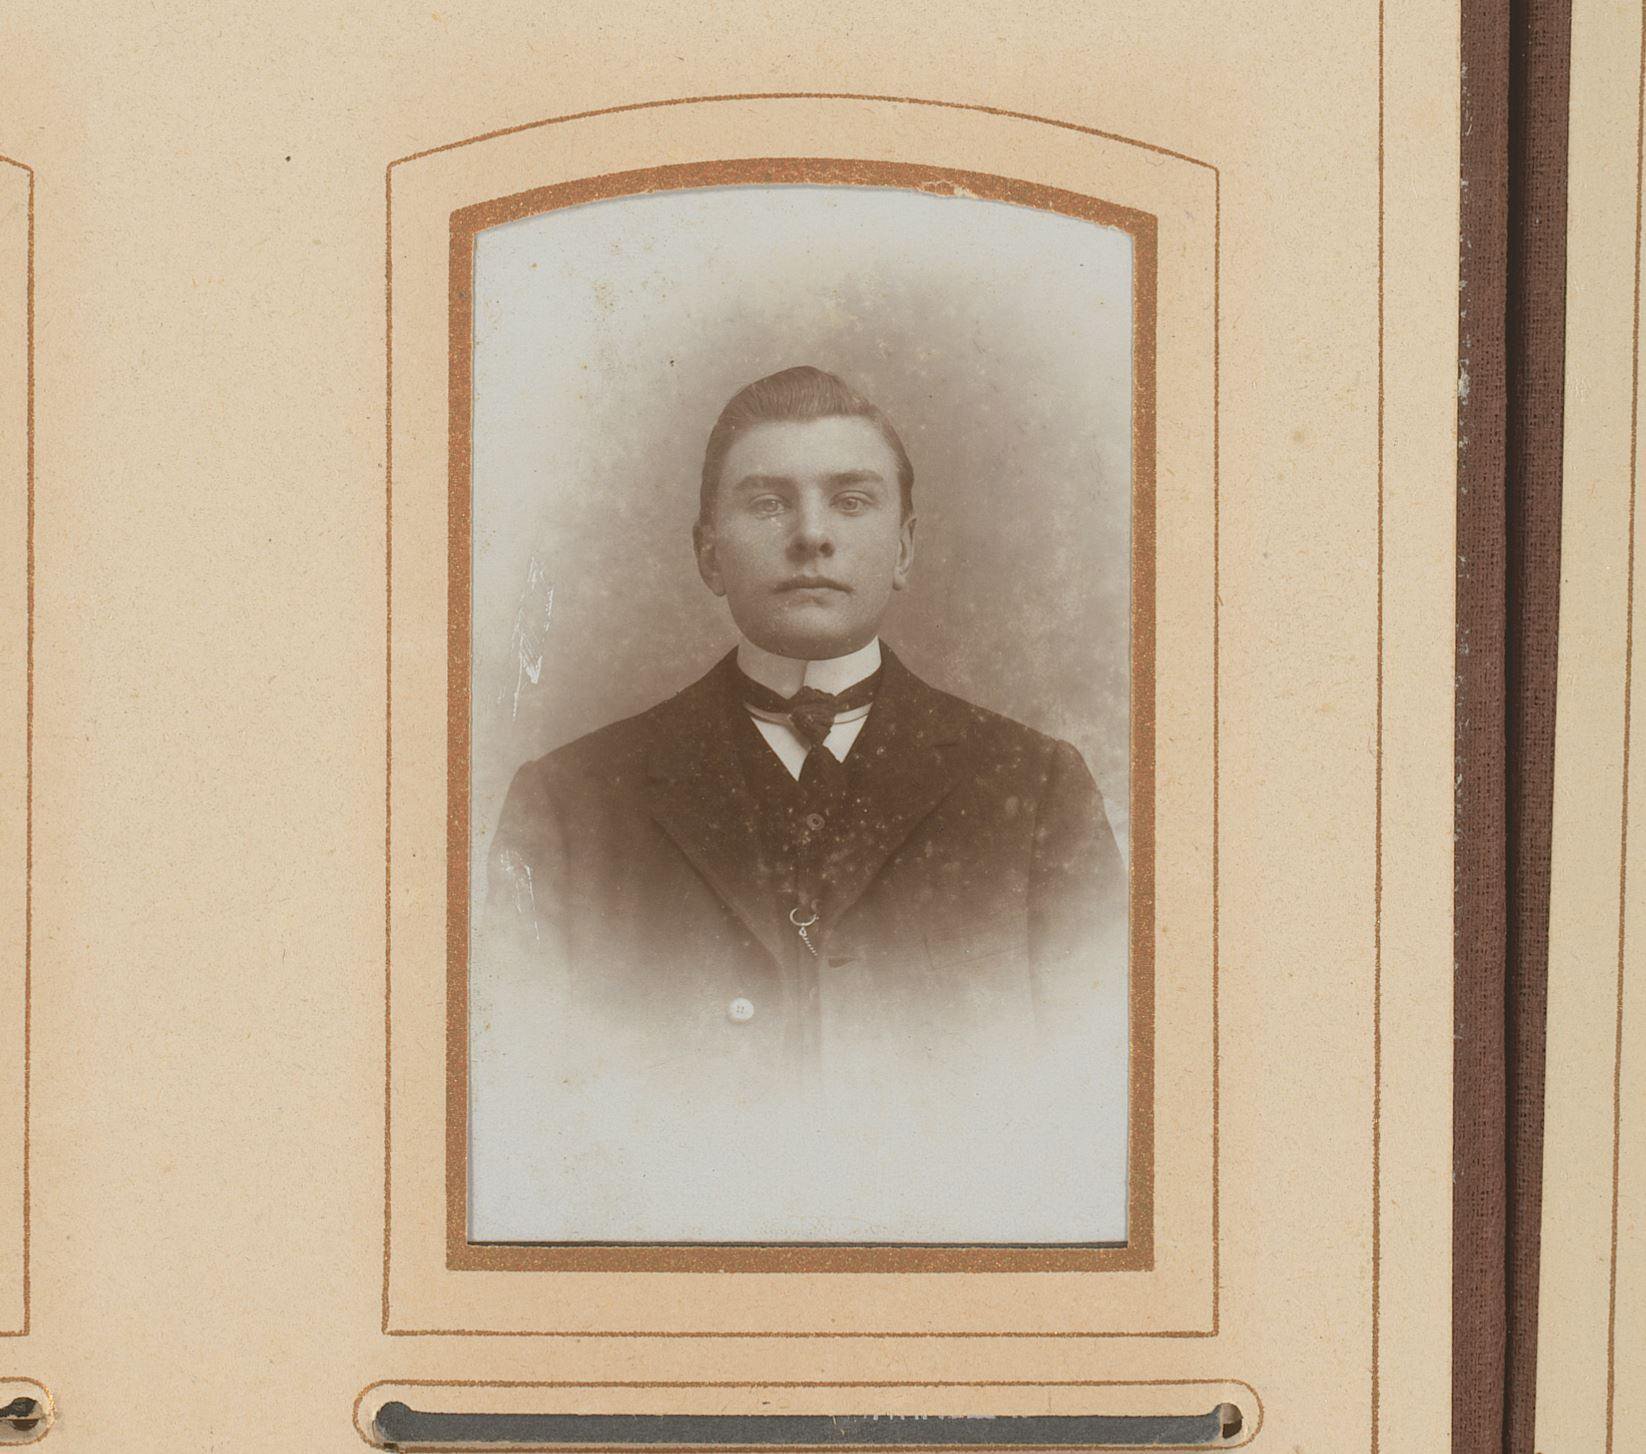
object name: photograph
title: Portret van een jongeman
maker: jan van roon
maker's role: fotograaf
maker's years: 1879-1948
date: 1903-1940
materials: cardboard, photographic support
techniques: collodion silver print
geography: haarlem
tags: youth, adolescent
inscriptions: inscription: ‘J. van Roon/ Generaal Cronjestraat 41 en 43/ Haarlem’